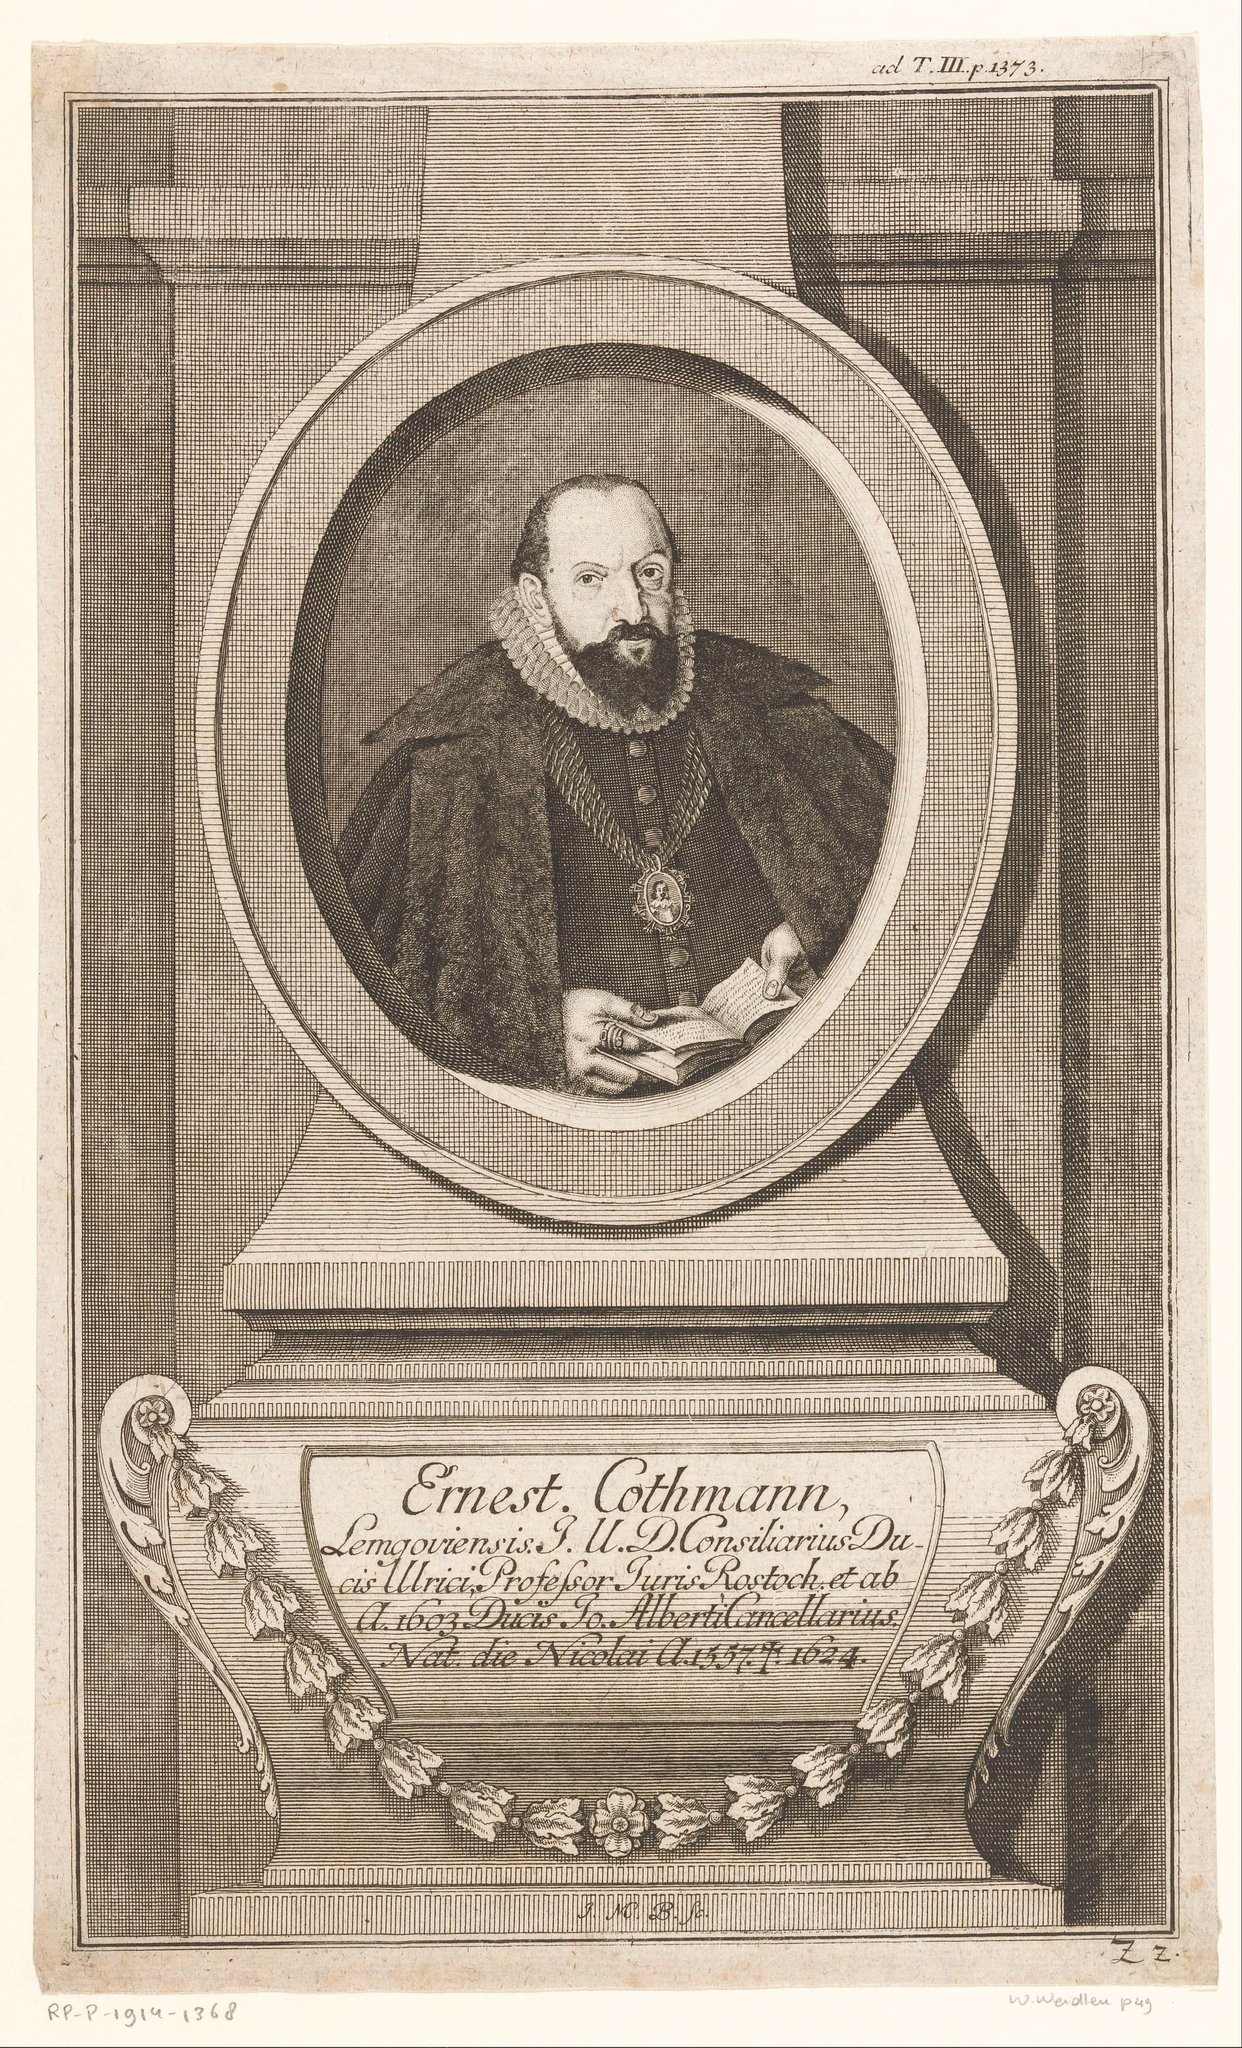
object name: print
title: Portret van Ernst Cothmann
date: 1743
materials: paper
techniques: engraving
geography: leipzig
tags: historical persons, book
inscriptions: collector's mark: Lugt 2228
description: Prent afkomstig uit: Westphalen, Ernst Joachim von. Monumenta Inedita Rerum Germanicarum Praecipue Cimbricarum Et Megapolensium (...). 4 dln. Leipzig: Johann Christian Martini, 1739-1745, dl. 3 (1743), p. 1373.